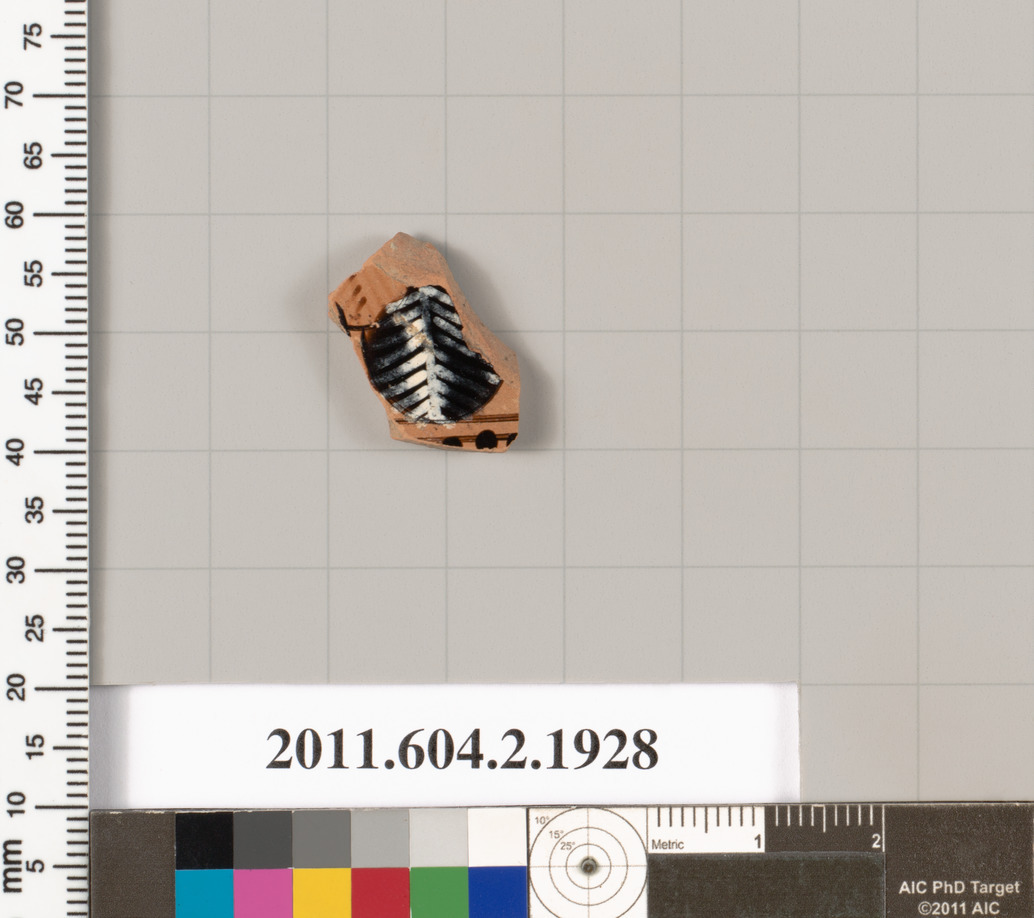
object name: skyphos fragment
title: Terracotta fragment of a skyphos (deep drinking cup)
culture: greek, attic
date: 475-425 BCE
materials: terracotta